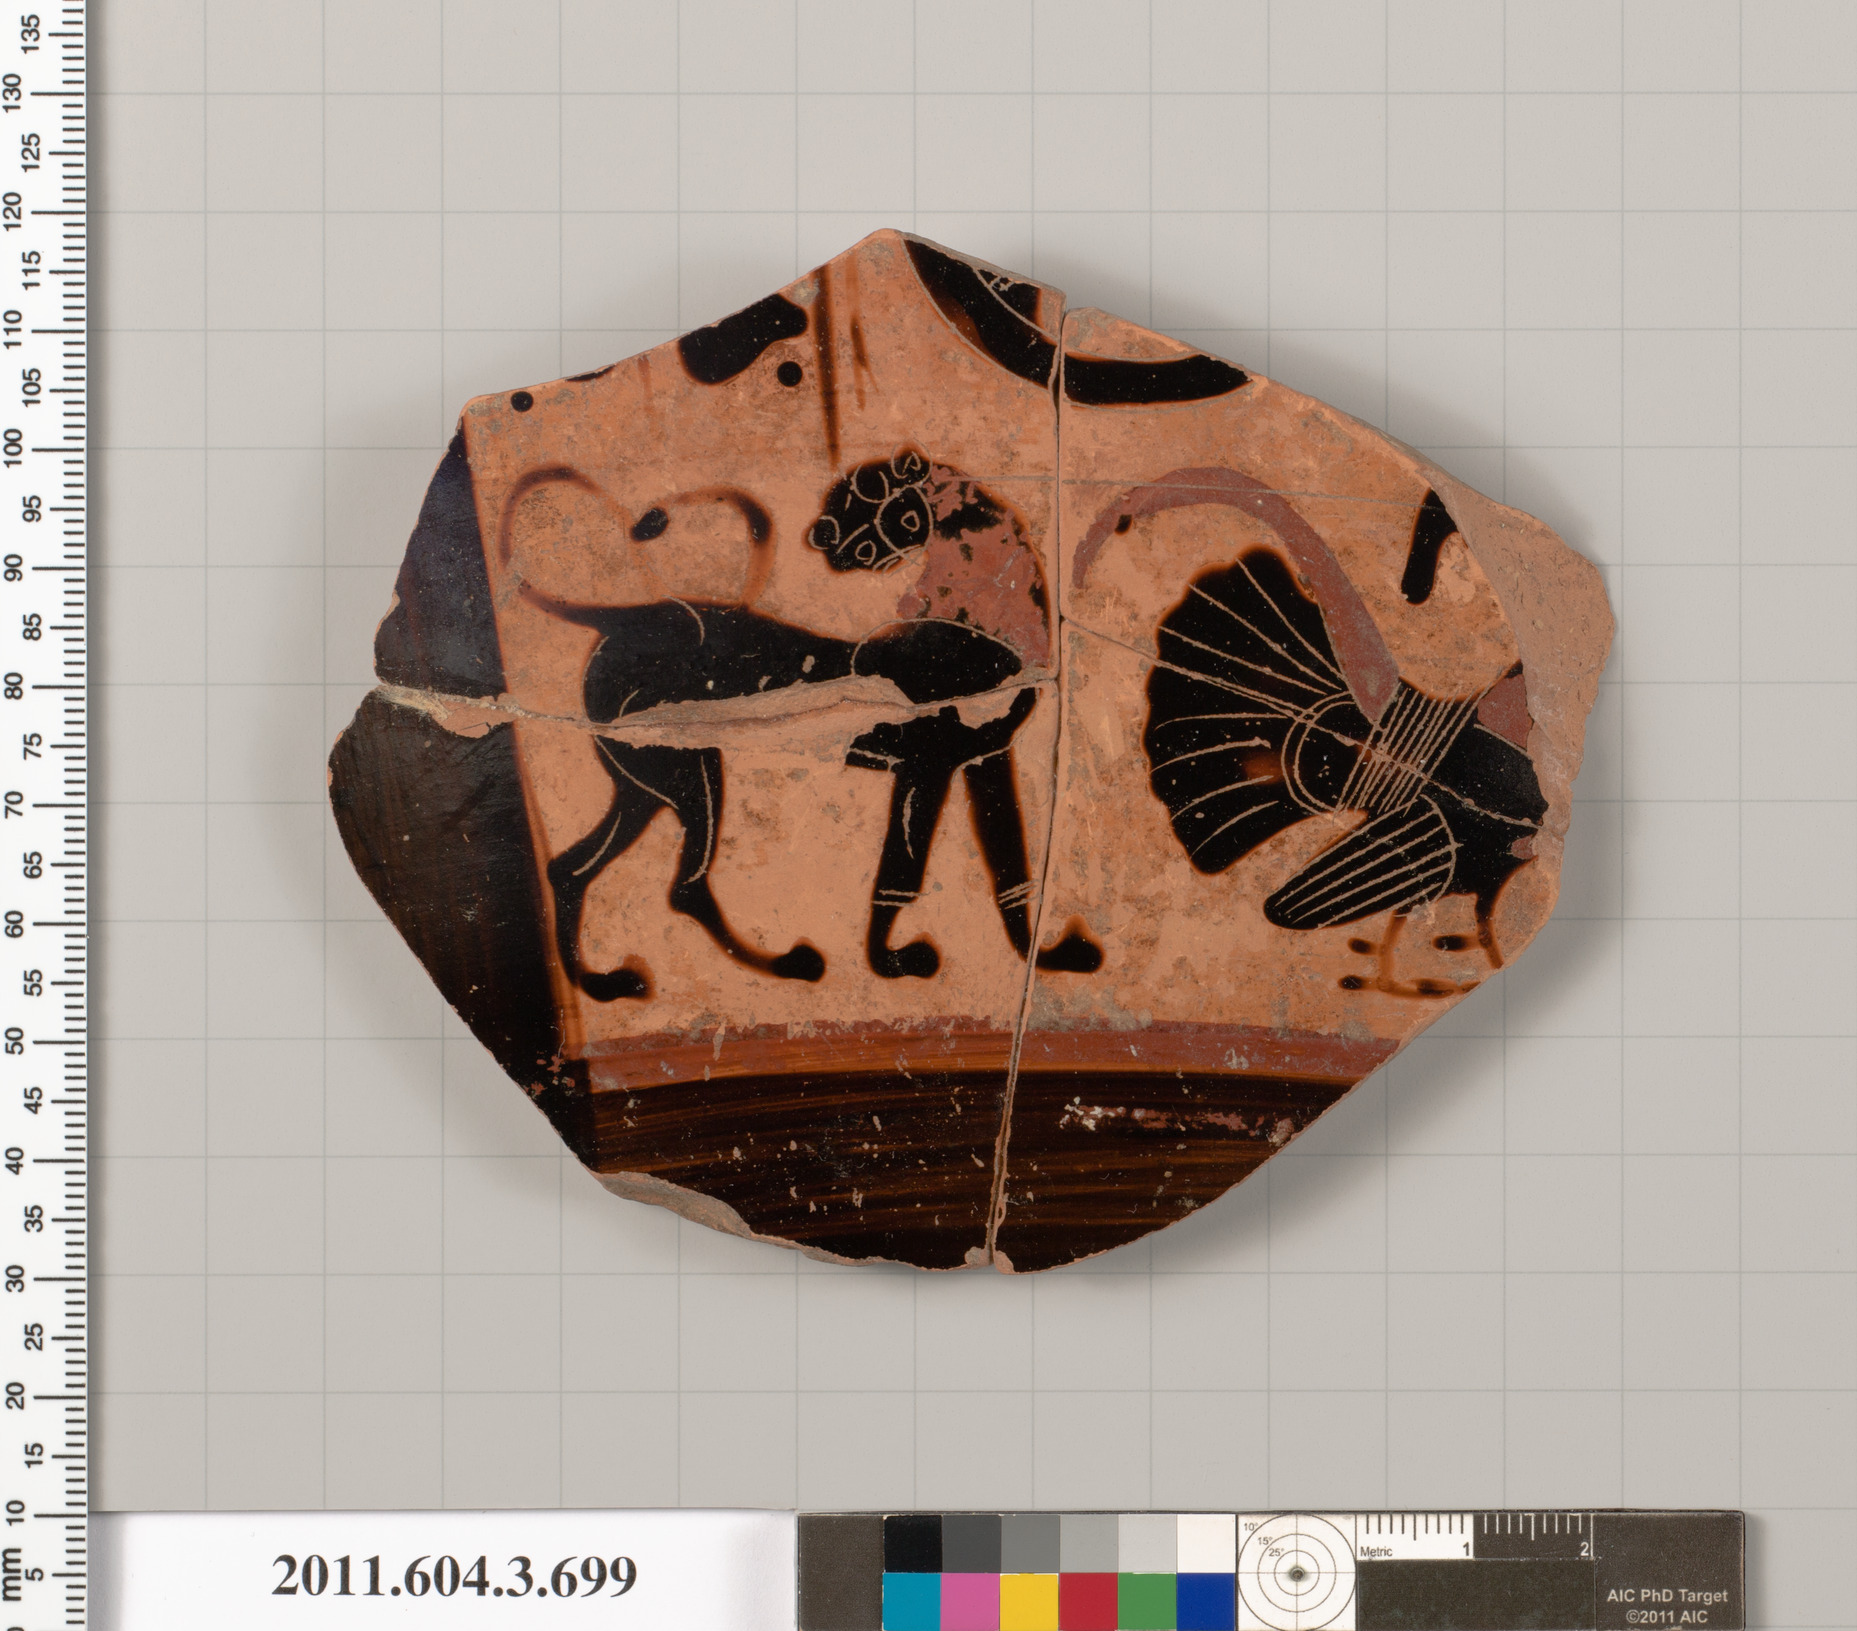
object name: hydria fragment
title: Terracotta fragment of a hydria (water jar)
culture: greek, attic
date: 575-551 BCE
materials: terracotta